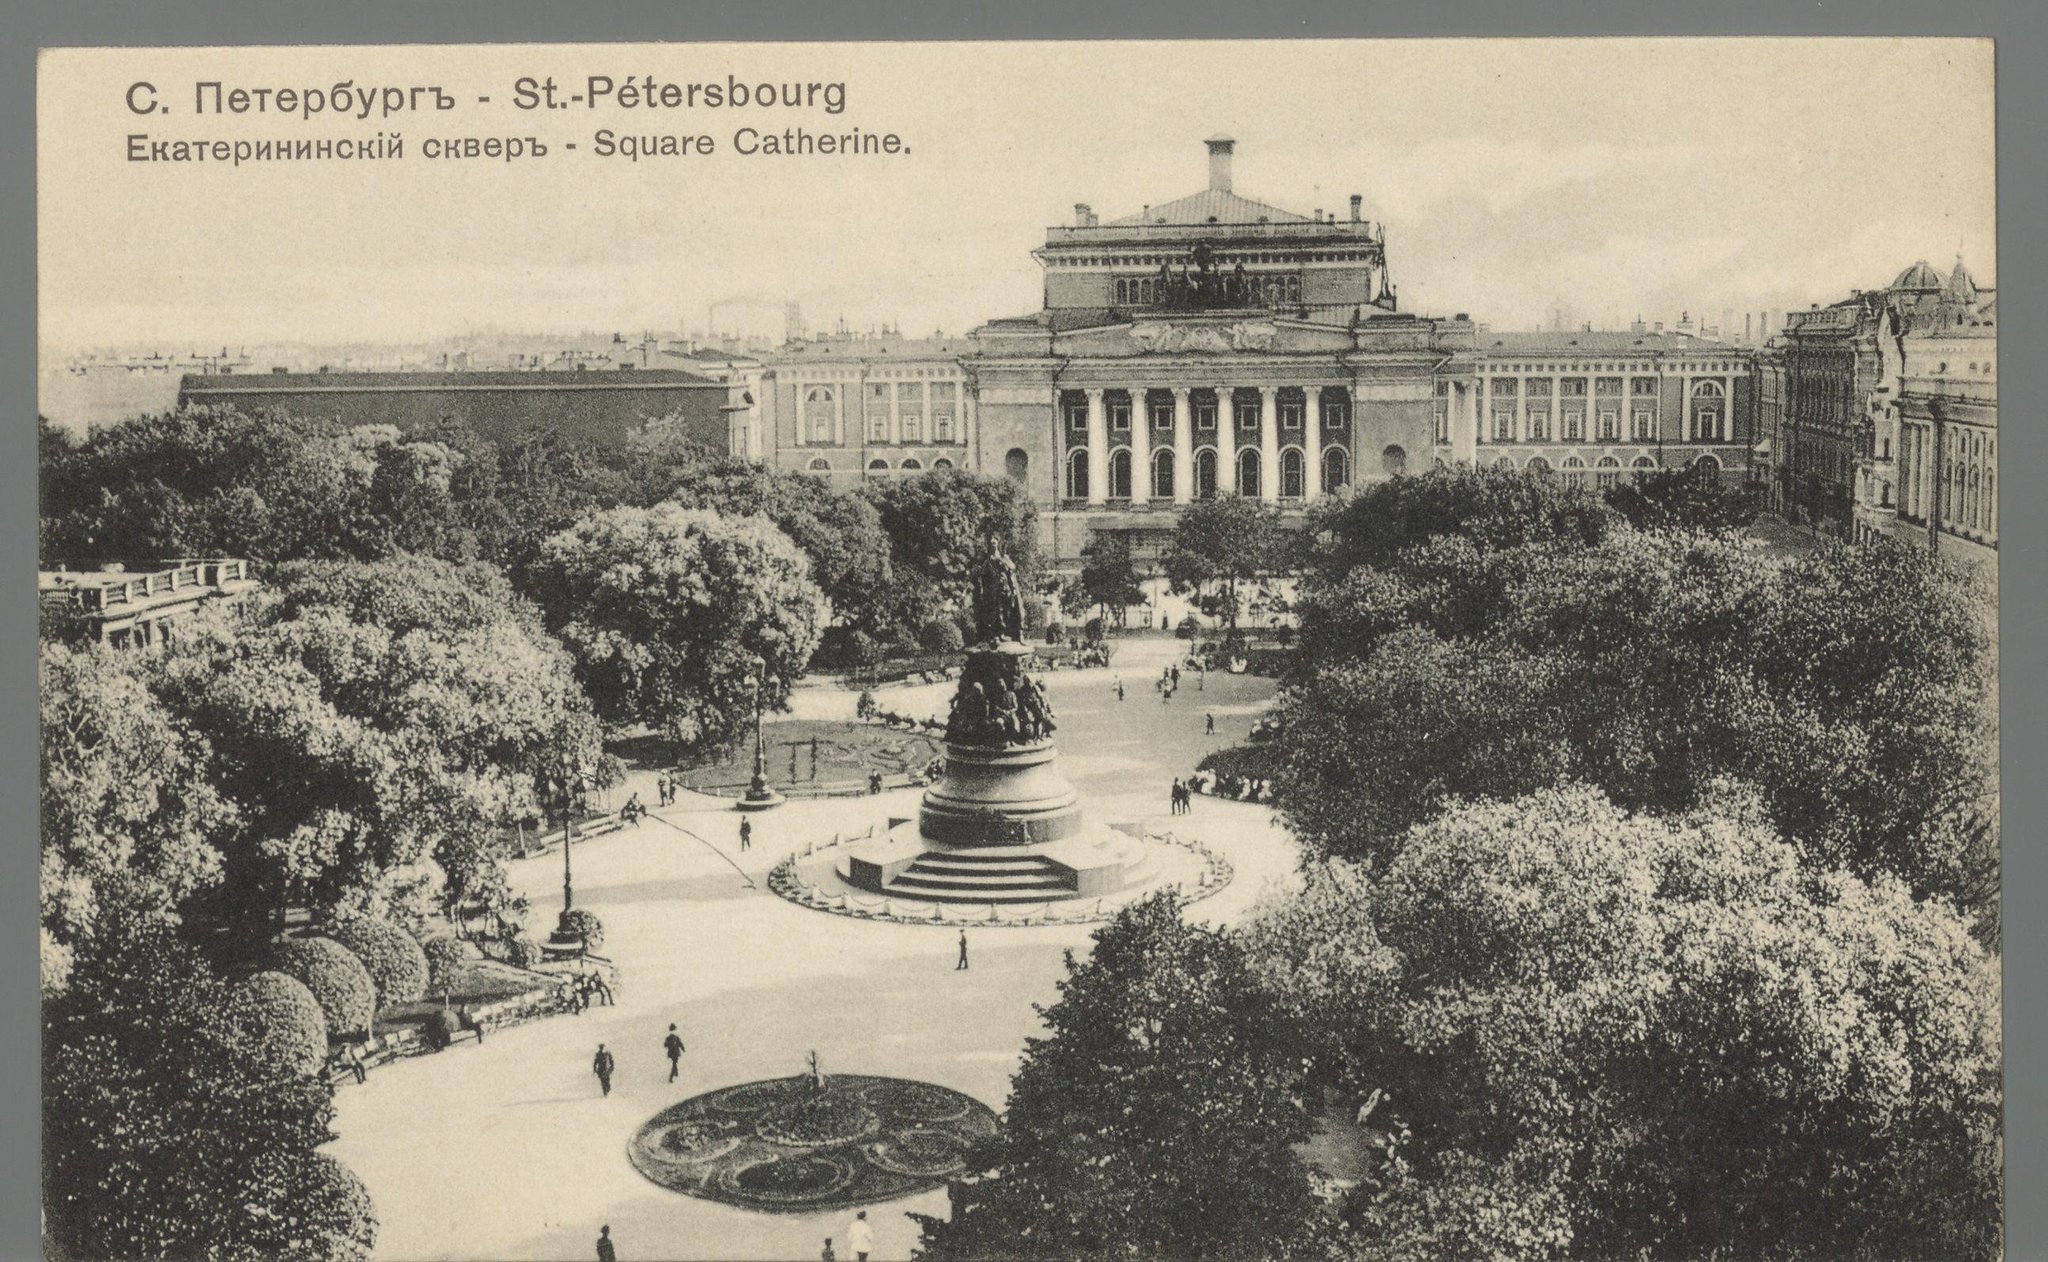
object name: ansichtkaart, prentbriefkaart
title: St.-Pétersbourg. Square Catherine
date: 1904-1930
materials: cardboard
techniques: photograph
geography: sint-petersburg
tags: catharina de grote, garden, monument, statue, emperor - bb - female ruler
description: Voor de Franse titel staat de titel in het Russisch.